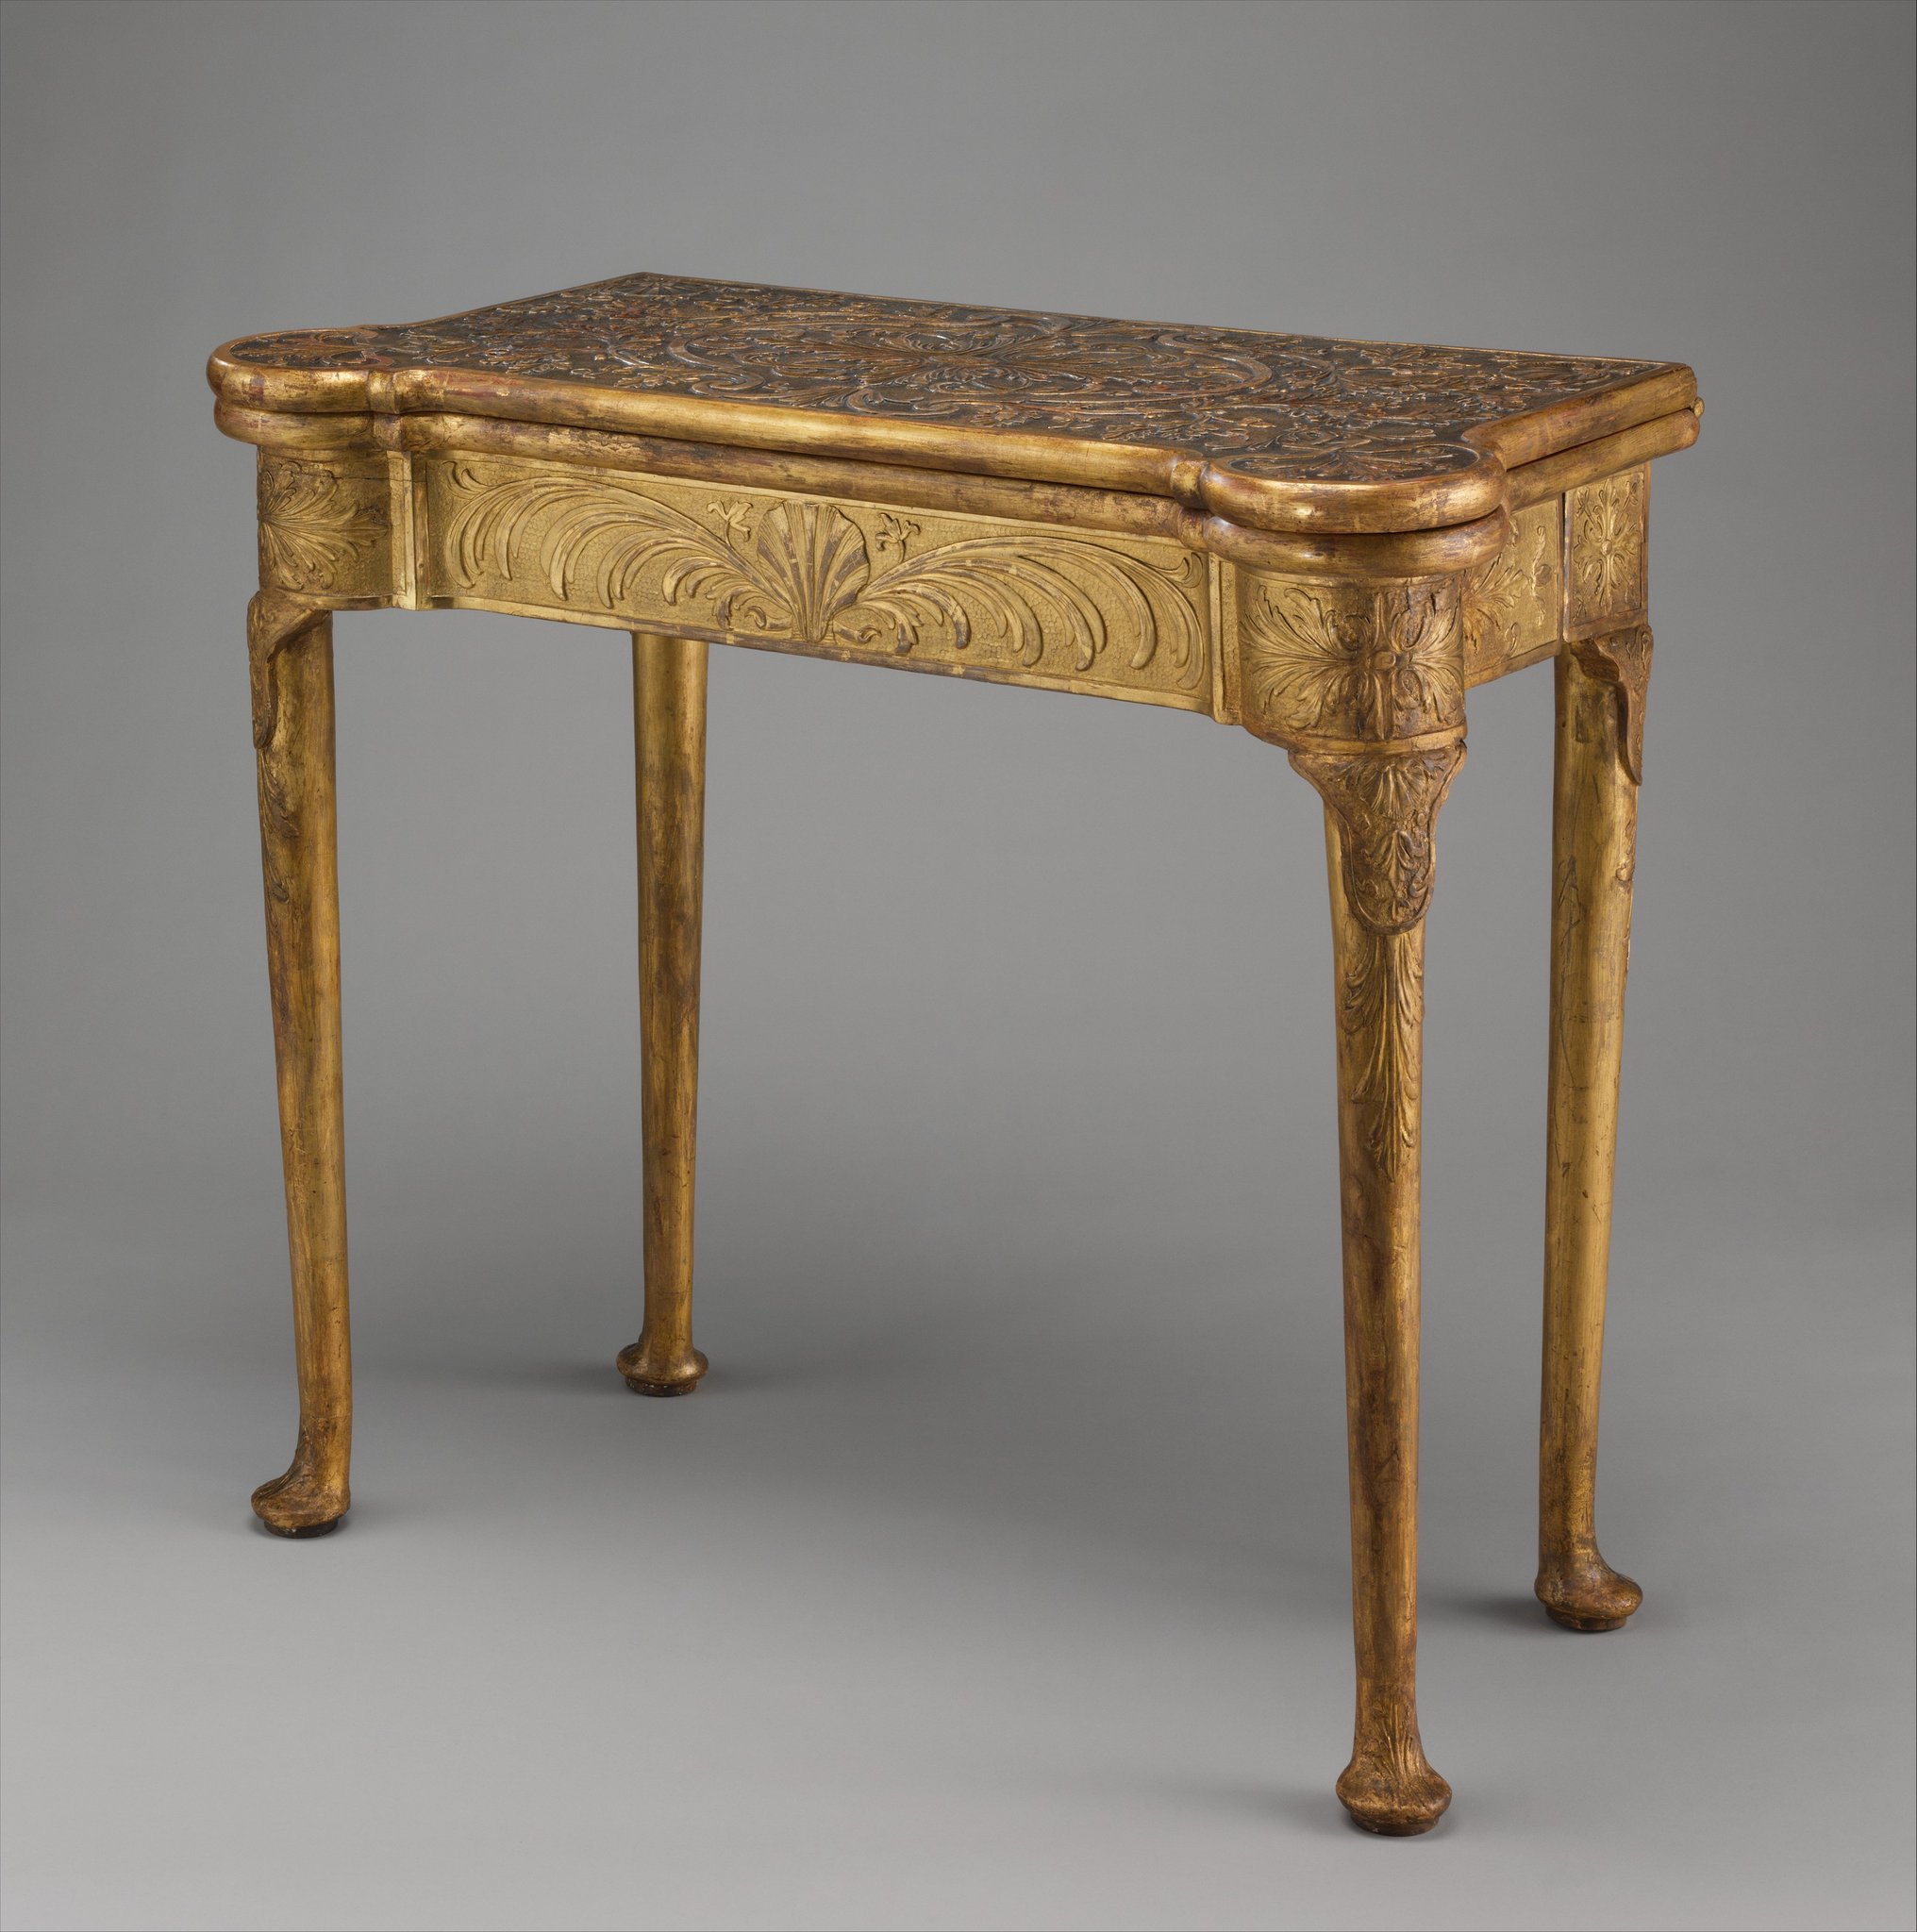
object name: card table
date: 1720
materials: felt, gesso, iron, wood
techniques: carving, gilding